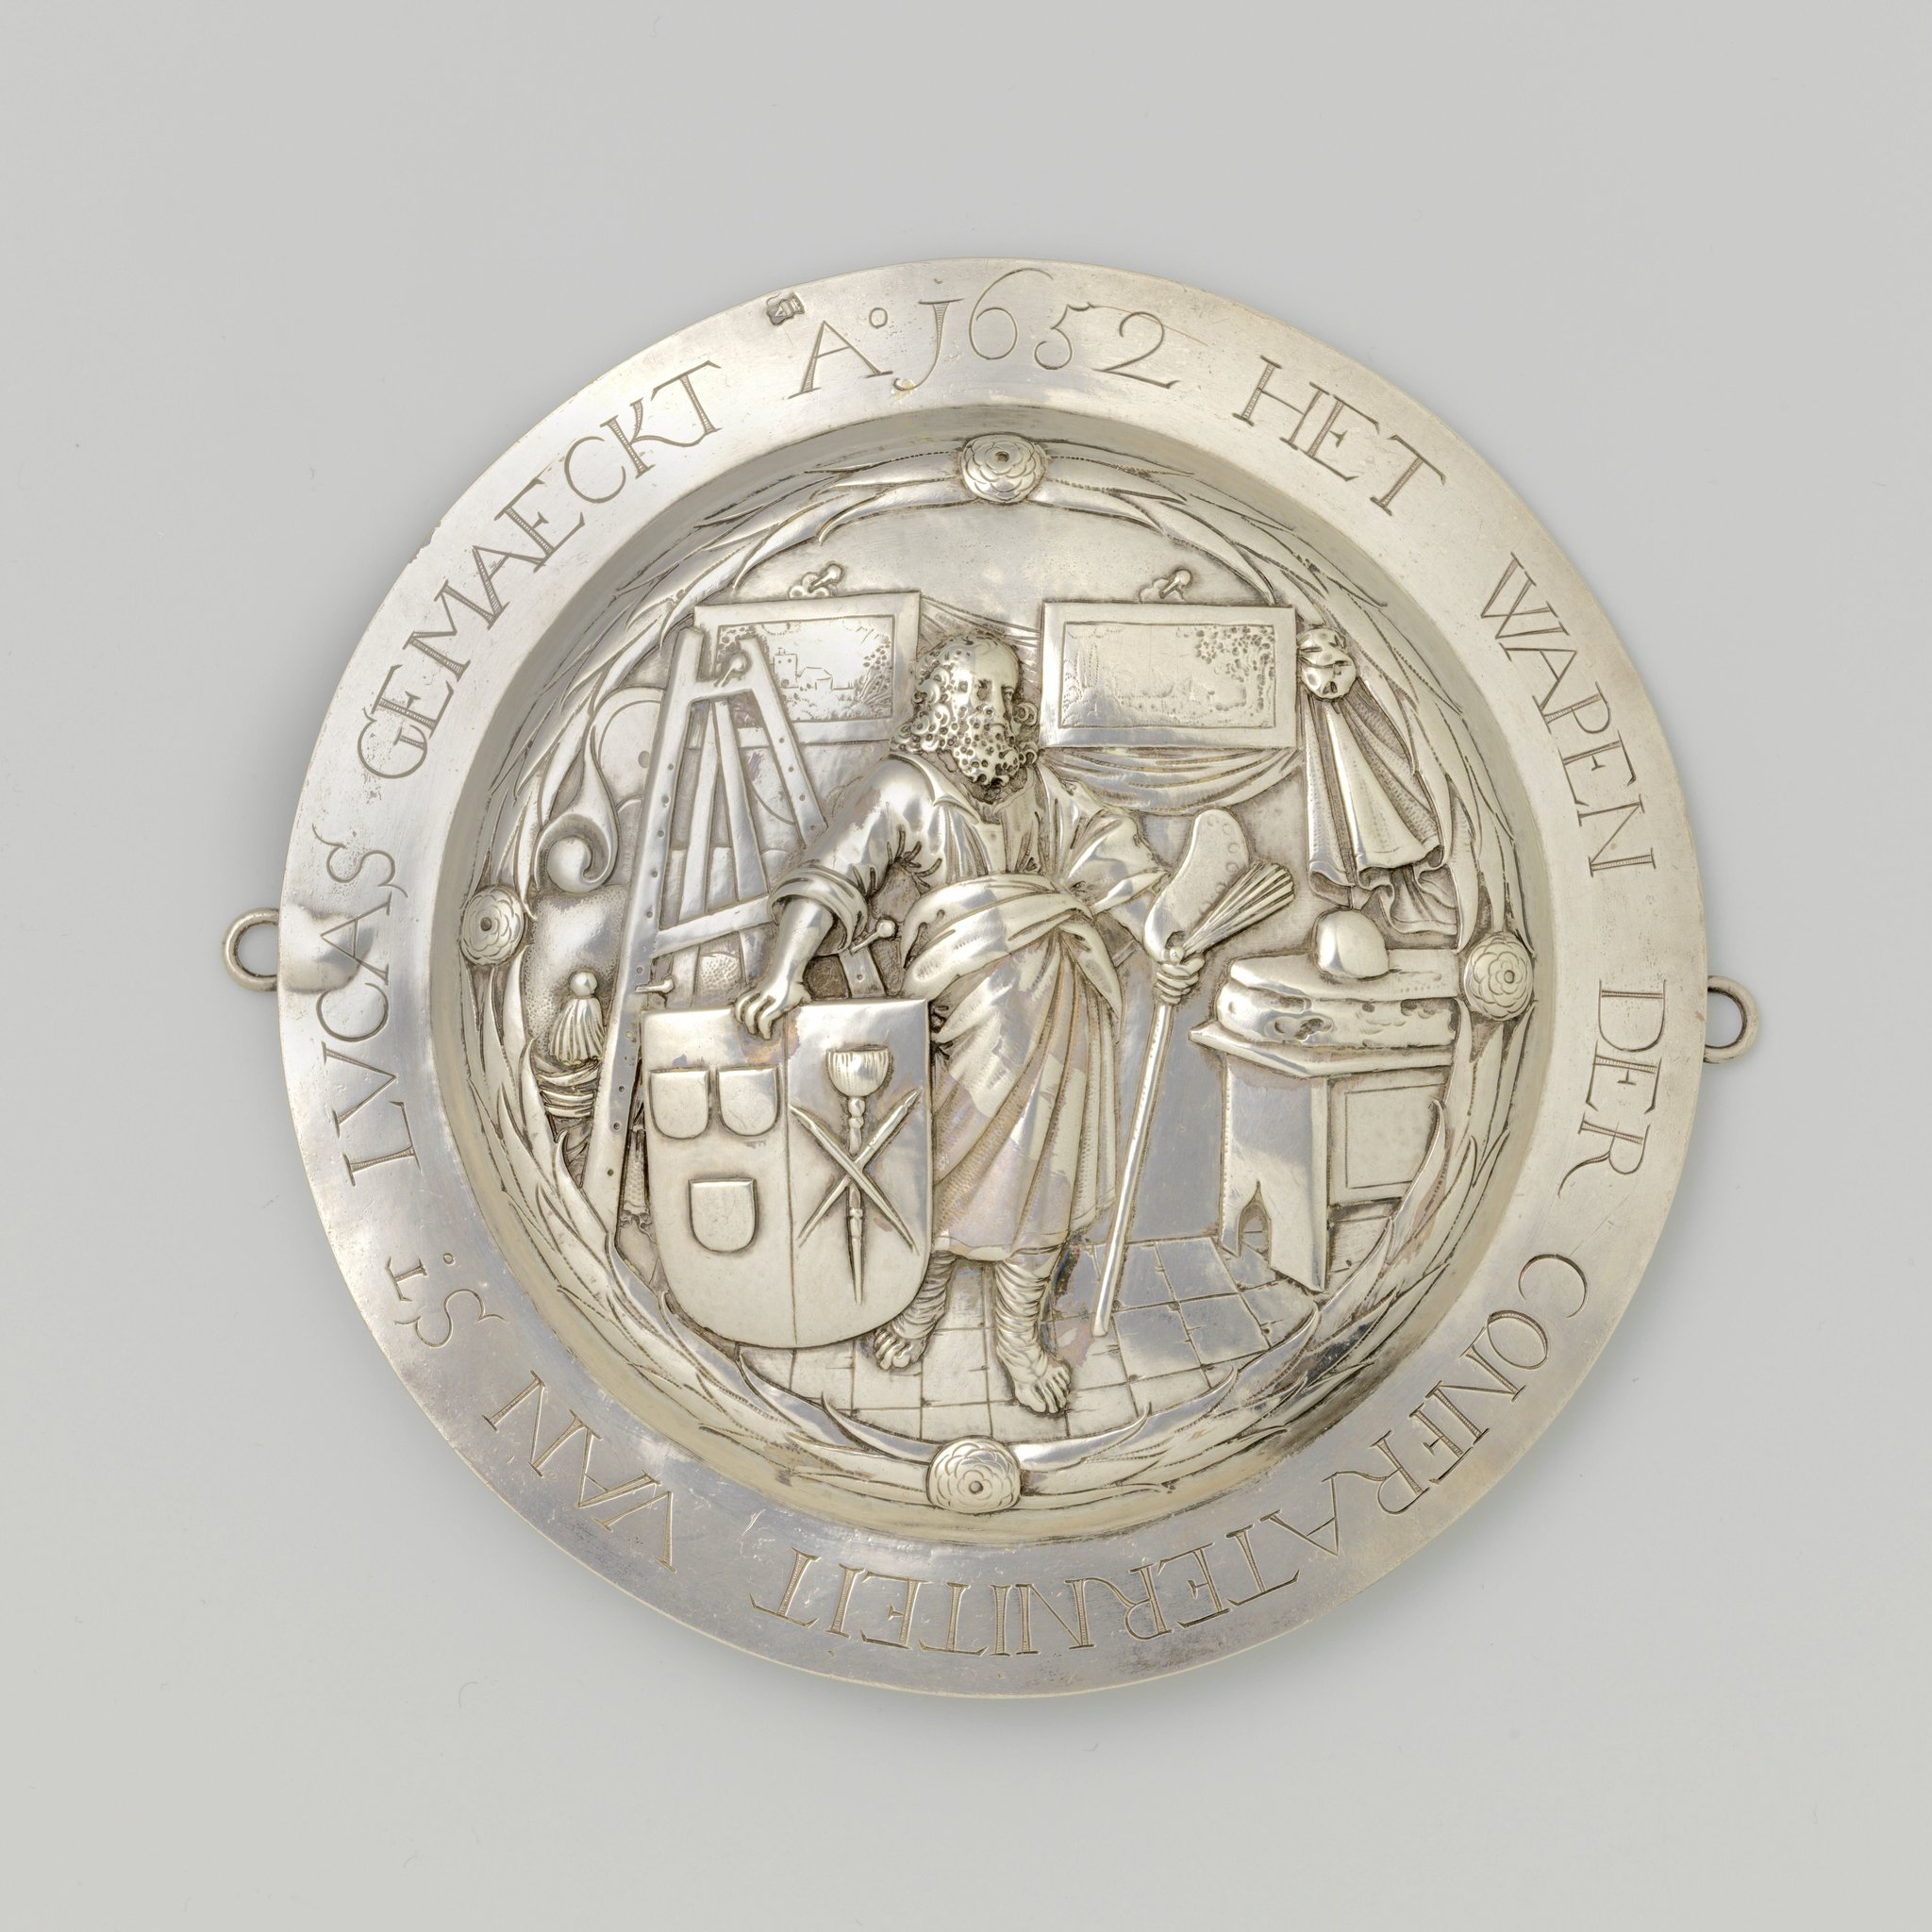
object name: gildeschild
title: St. Lucasgilde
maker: Anonymous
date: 1650-1675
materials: silver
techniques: engraving, forging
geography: northern netherlands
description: Een zilveren schild, dat de voorstelling draagt van een schilder in zijn werkplaats met in zijn linkerhand het palet, penselen en een schilderstok en in zijn rechterhand het wapen van het gilde. Op de achtergrond links een fornuis en in het midden-boven twee opgehangen schilderijen; rechts een schildersezel. De afbeelding is rondom versierd met blad- en bloemmotieven. In het midden is zowel links als rechts een klein ringetje bevestigd. Opschrift: HET WAPEN DER CONFRATERNITEIT VAN St. LUCAS GEMAECKT Ao 1652